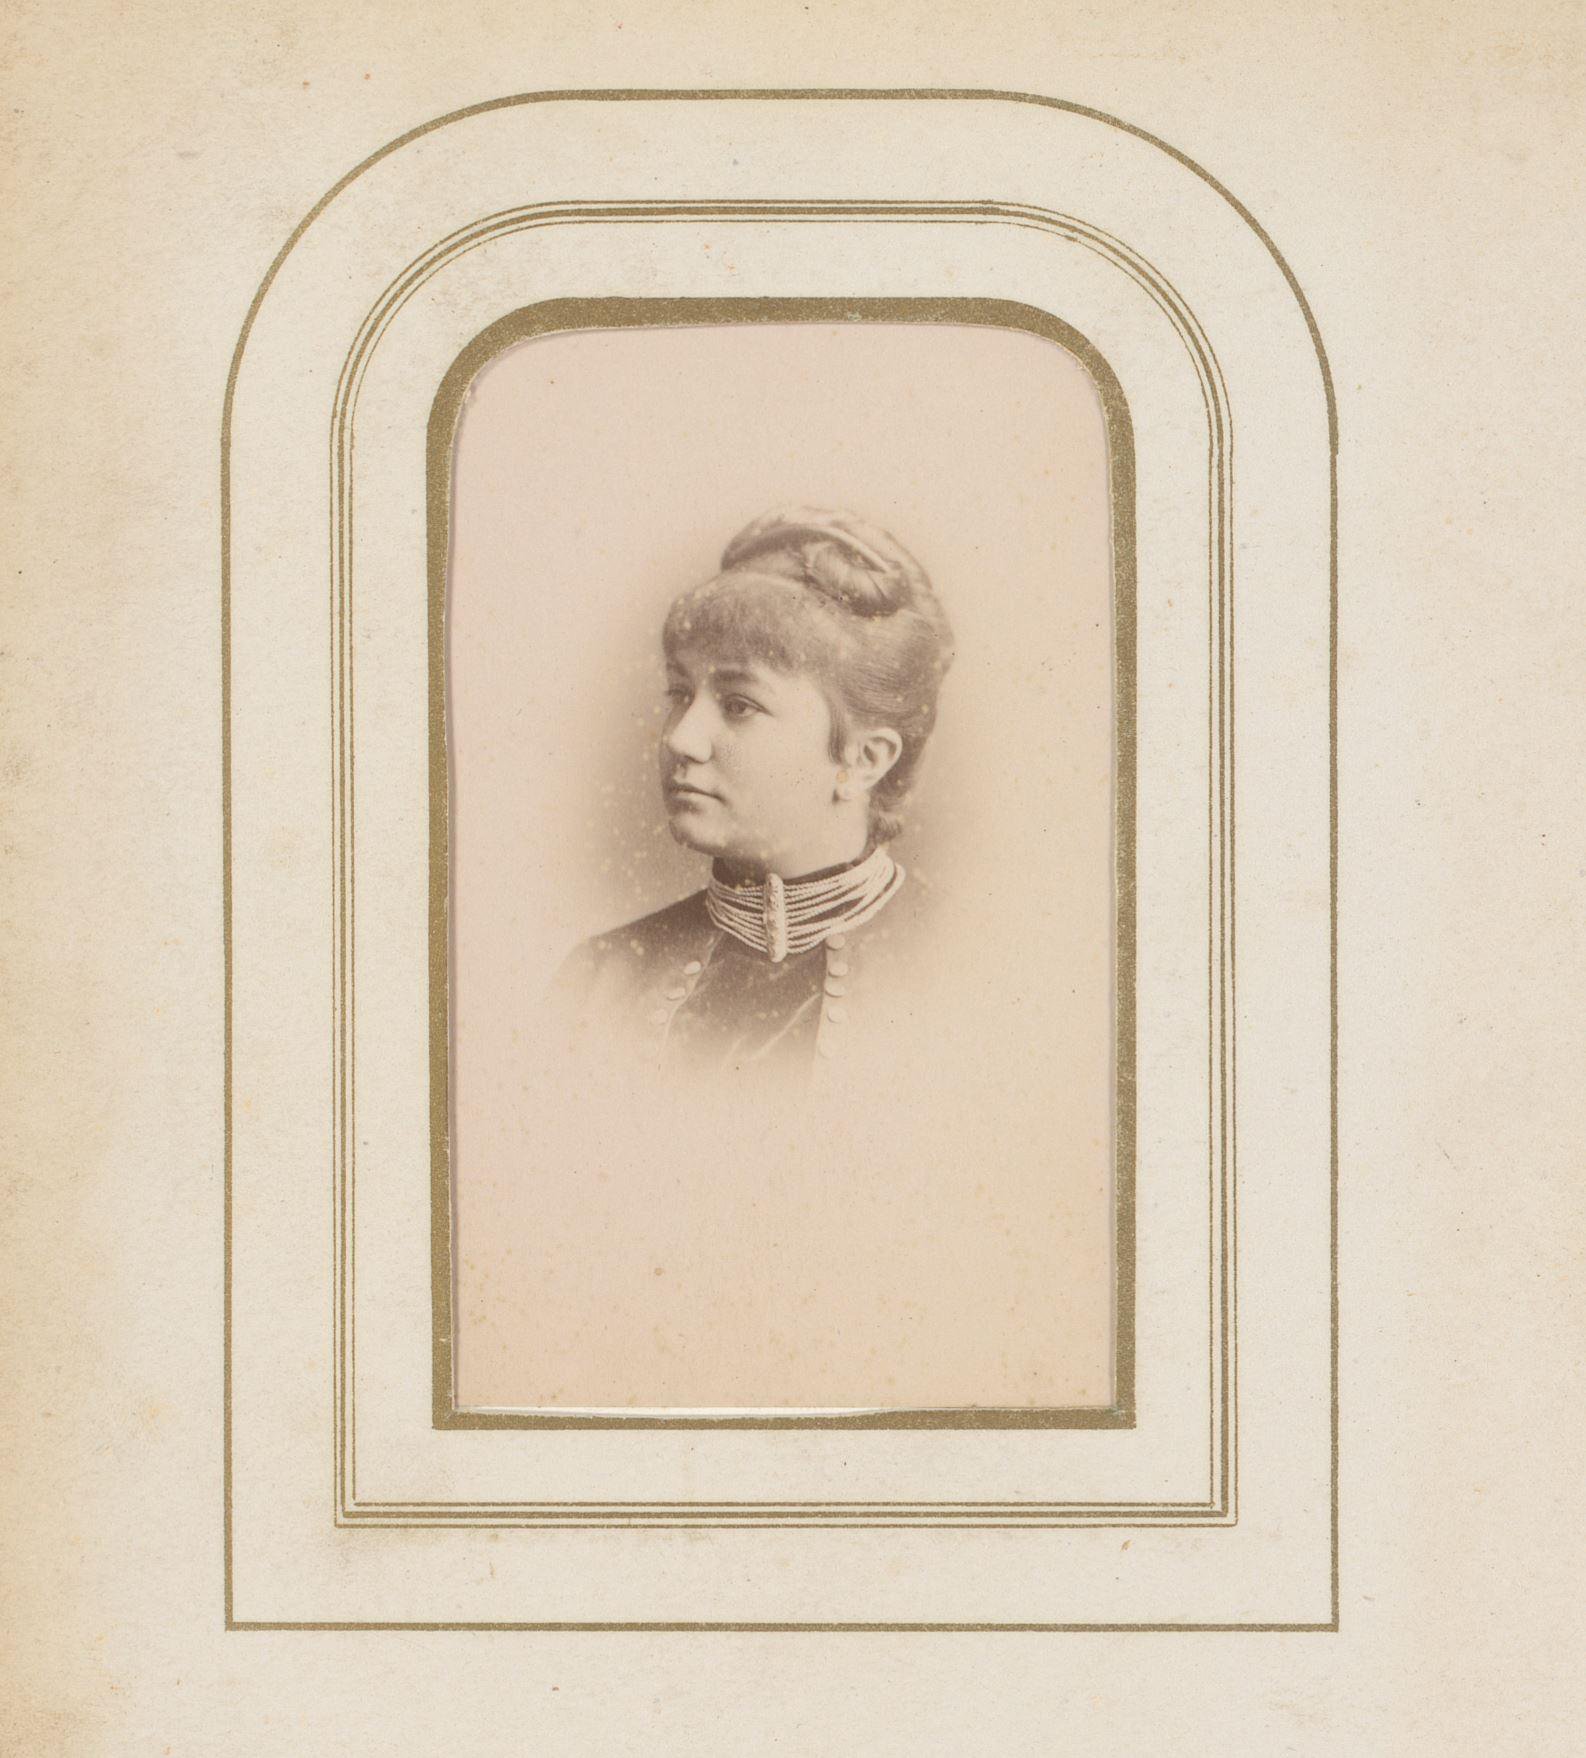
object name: carte de visite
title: Portret van een vrouw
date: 1860-1890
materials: cardboard, photographic support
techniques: albumen print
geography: luxembourg city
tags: historical persons - bb - woman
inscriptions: inscription: ‘Etablissement/ Photographique de/ Ch. Brandebourg fils/ Luxembourg/ Coin Avenue Amelie et Boulevard du Prince (...)’